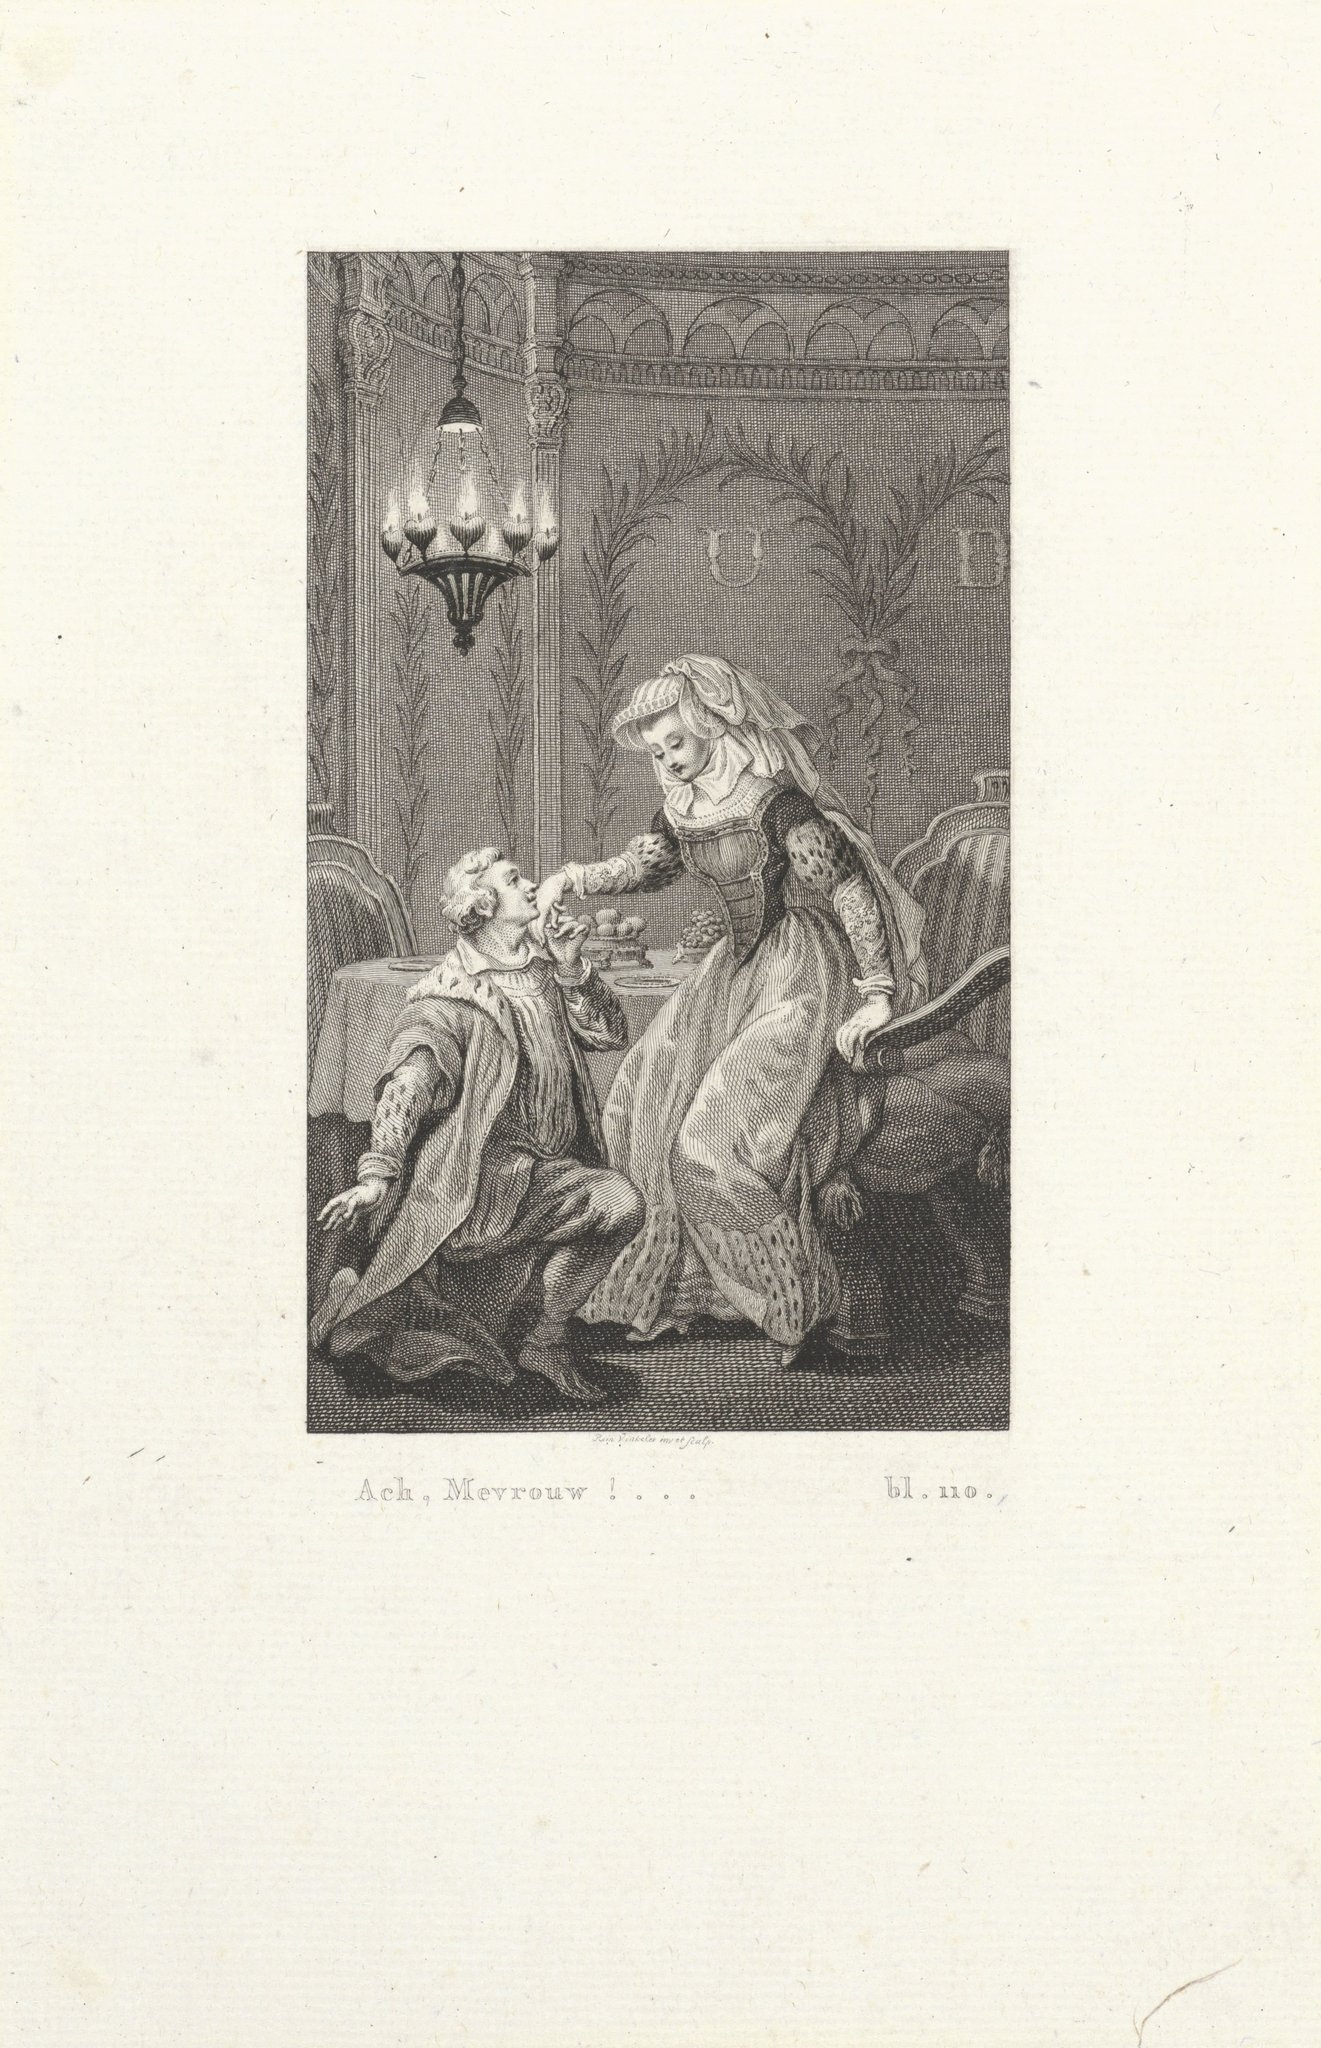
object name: print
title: Frank van Borselen knielt voor Jacoba van Beieren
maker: reinier vinkeles (i)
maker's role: draughtsman, print maker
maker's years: 1741-1816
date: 1790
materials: paper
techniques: engraving, etching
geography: amsterdam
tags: jacoba of bavaria (countess of hainaut), brielle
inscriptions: collector's mark: Lugt 240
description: Illustratie uit: Loosjes Pz, Adriaan. Frank van Borselen en Jacoba van Beijeren. Haarlem: Adriaan Loosjes Pz., 1790, p. 110.